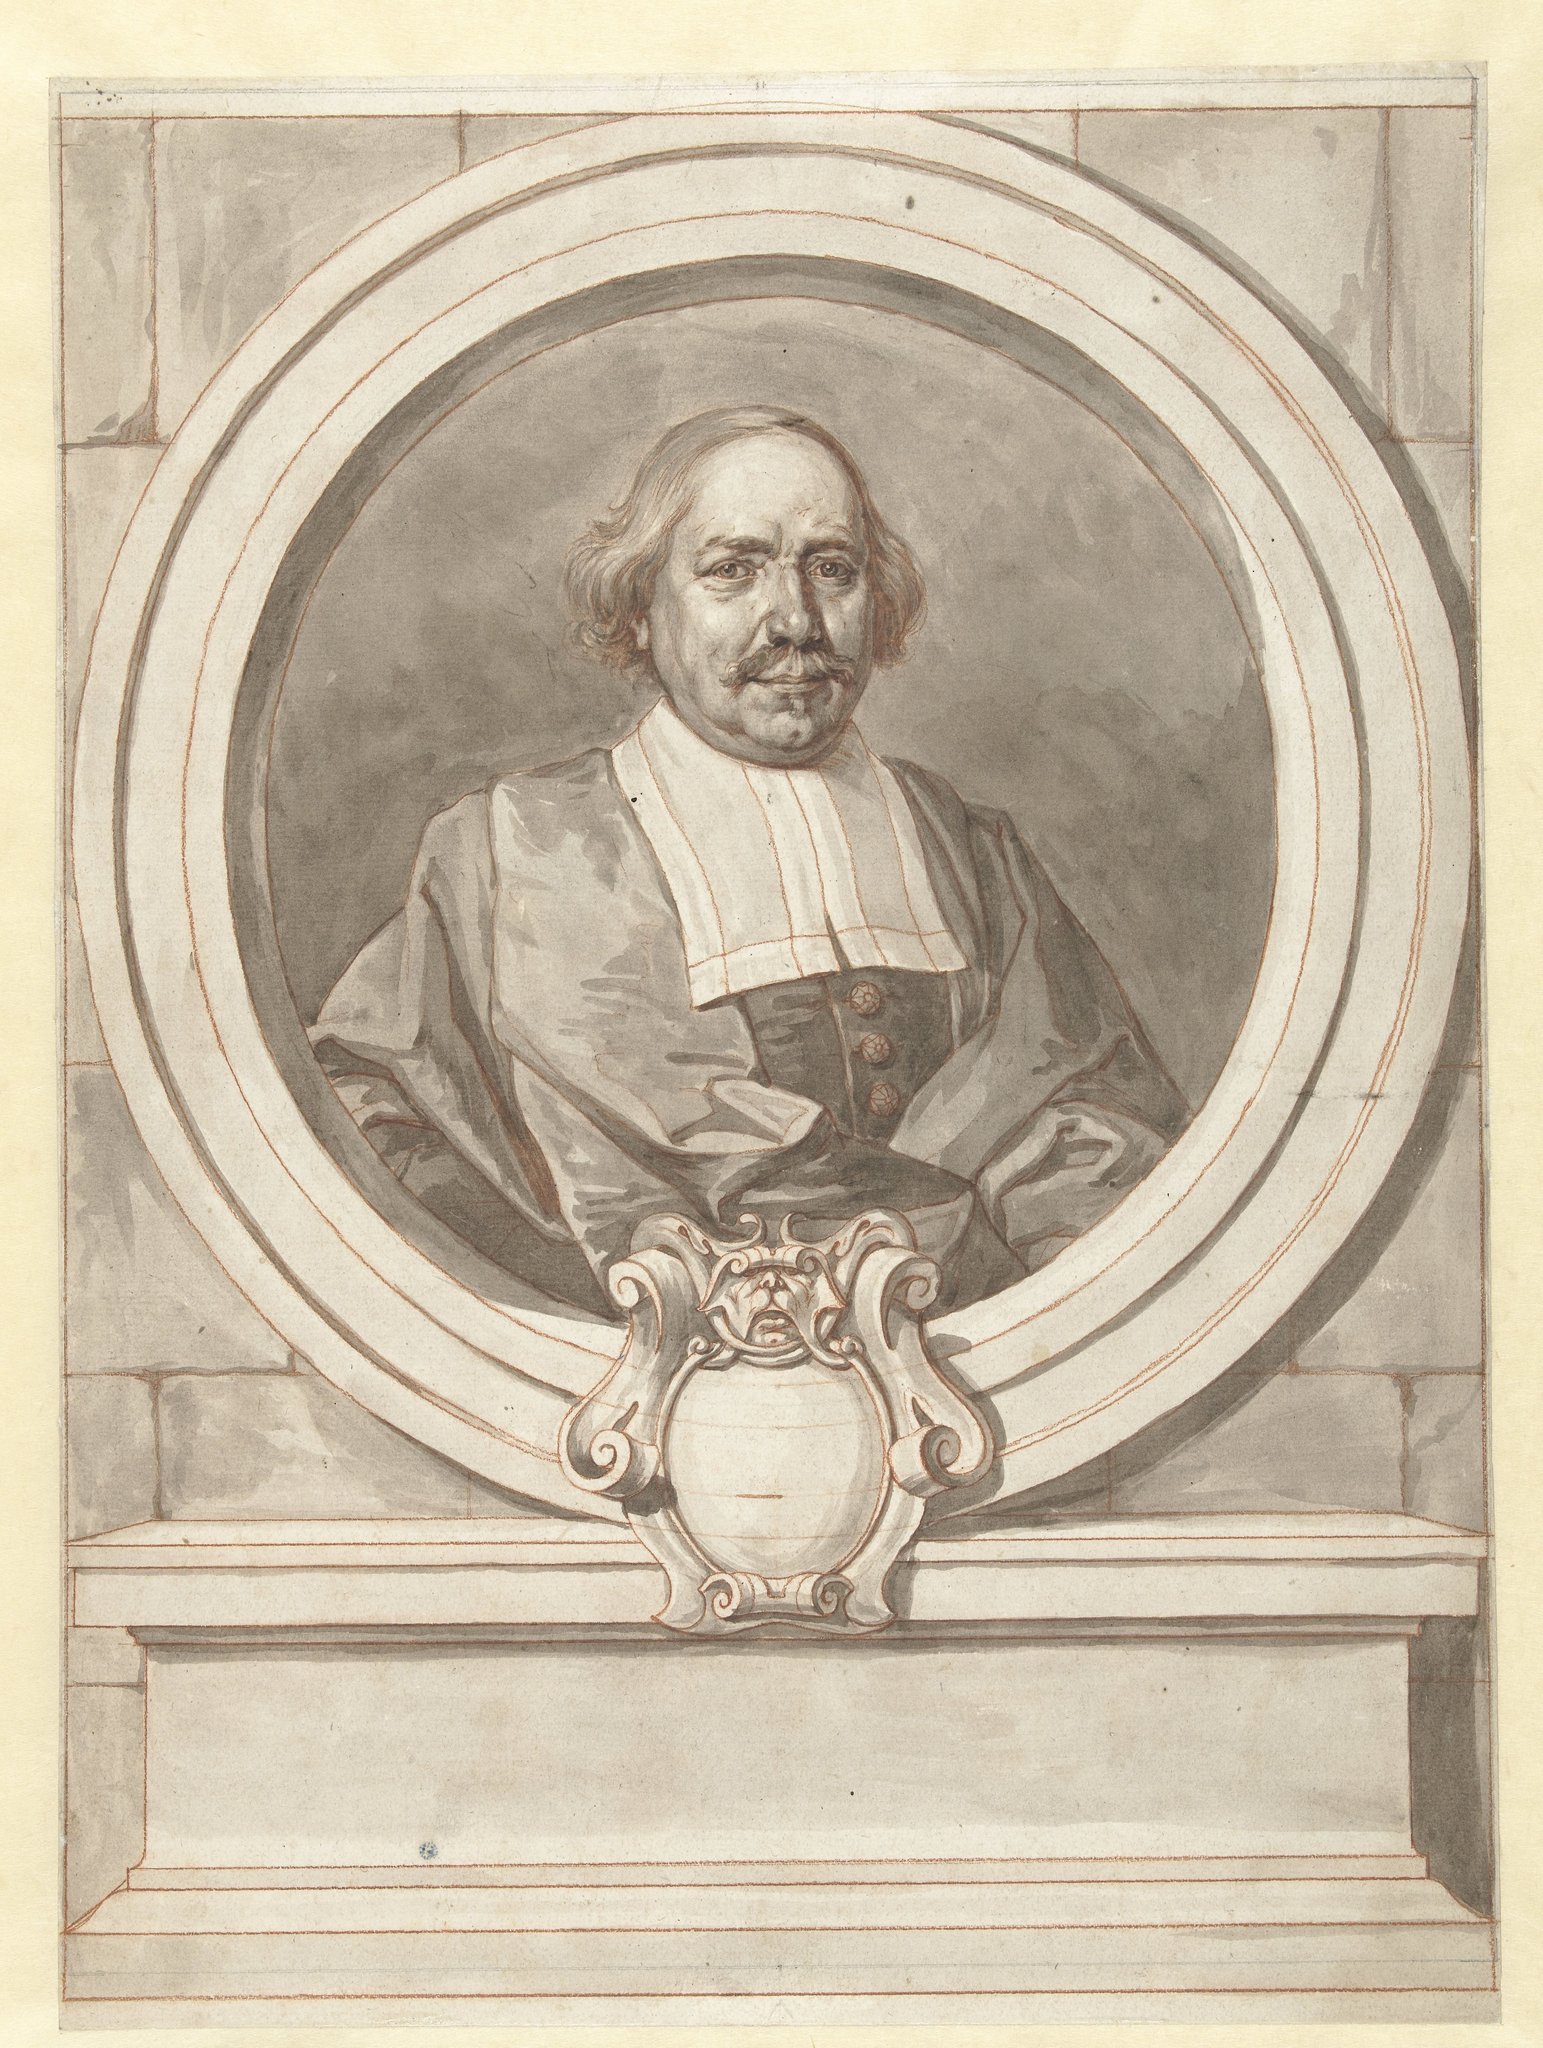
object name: drawing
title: Mansportret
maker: lambert visscher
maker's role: draughtsman, print maker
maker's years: 1640-1679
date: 1643-1695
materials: chalk, paper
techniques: brush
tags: anonymous historical person portrayed alone